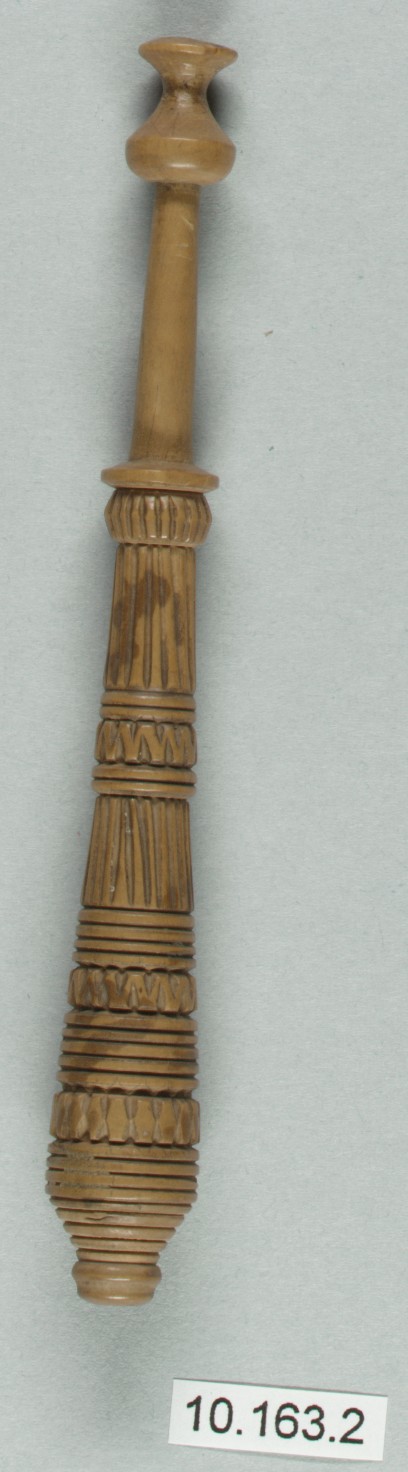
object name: bobbin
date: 1801-1900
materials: wood